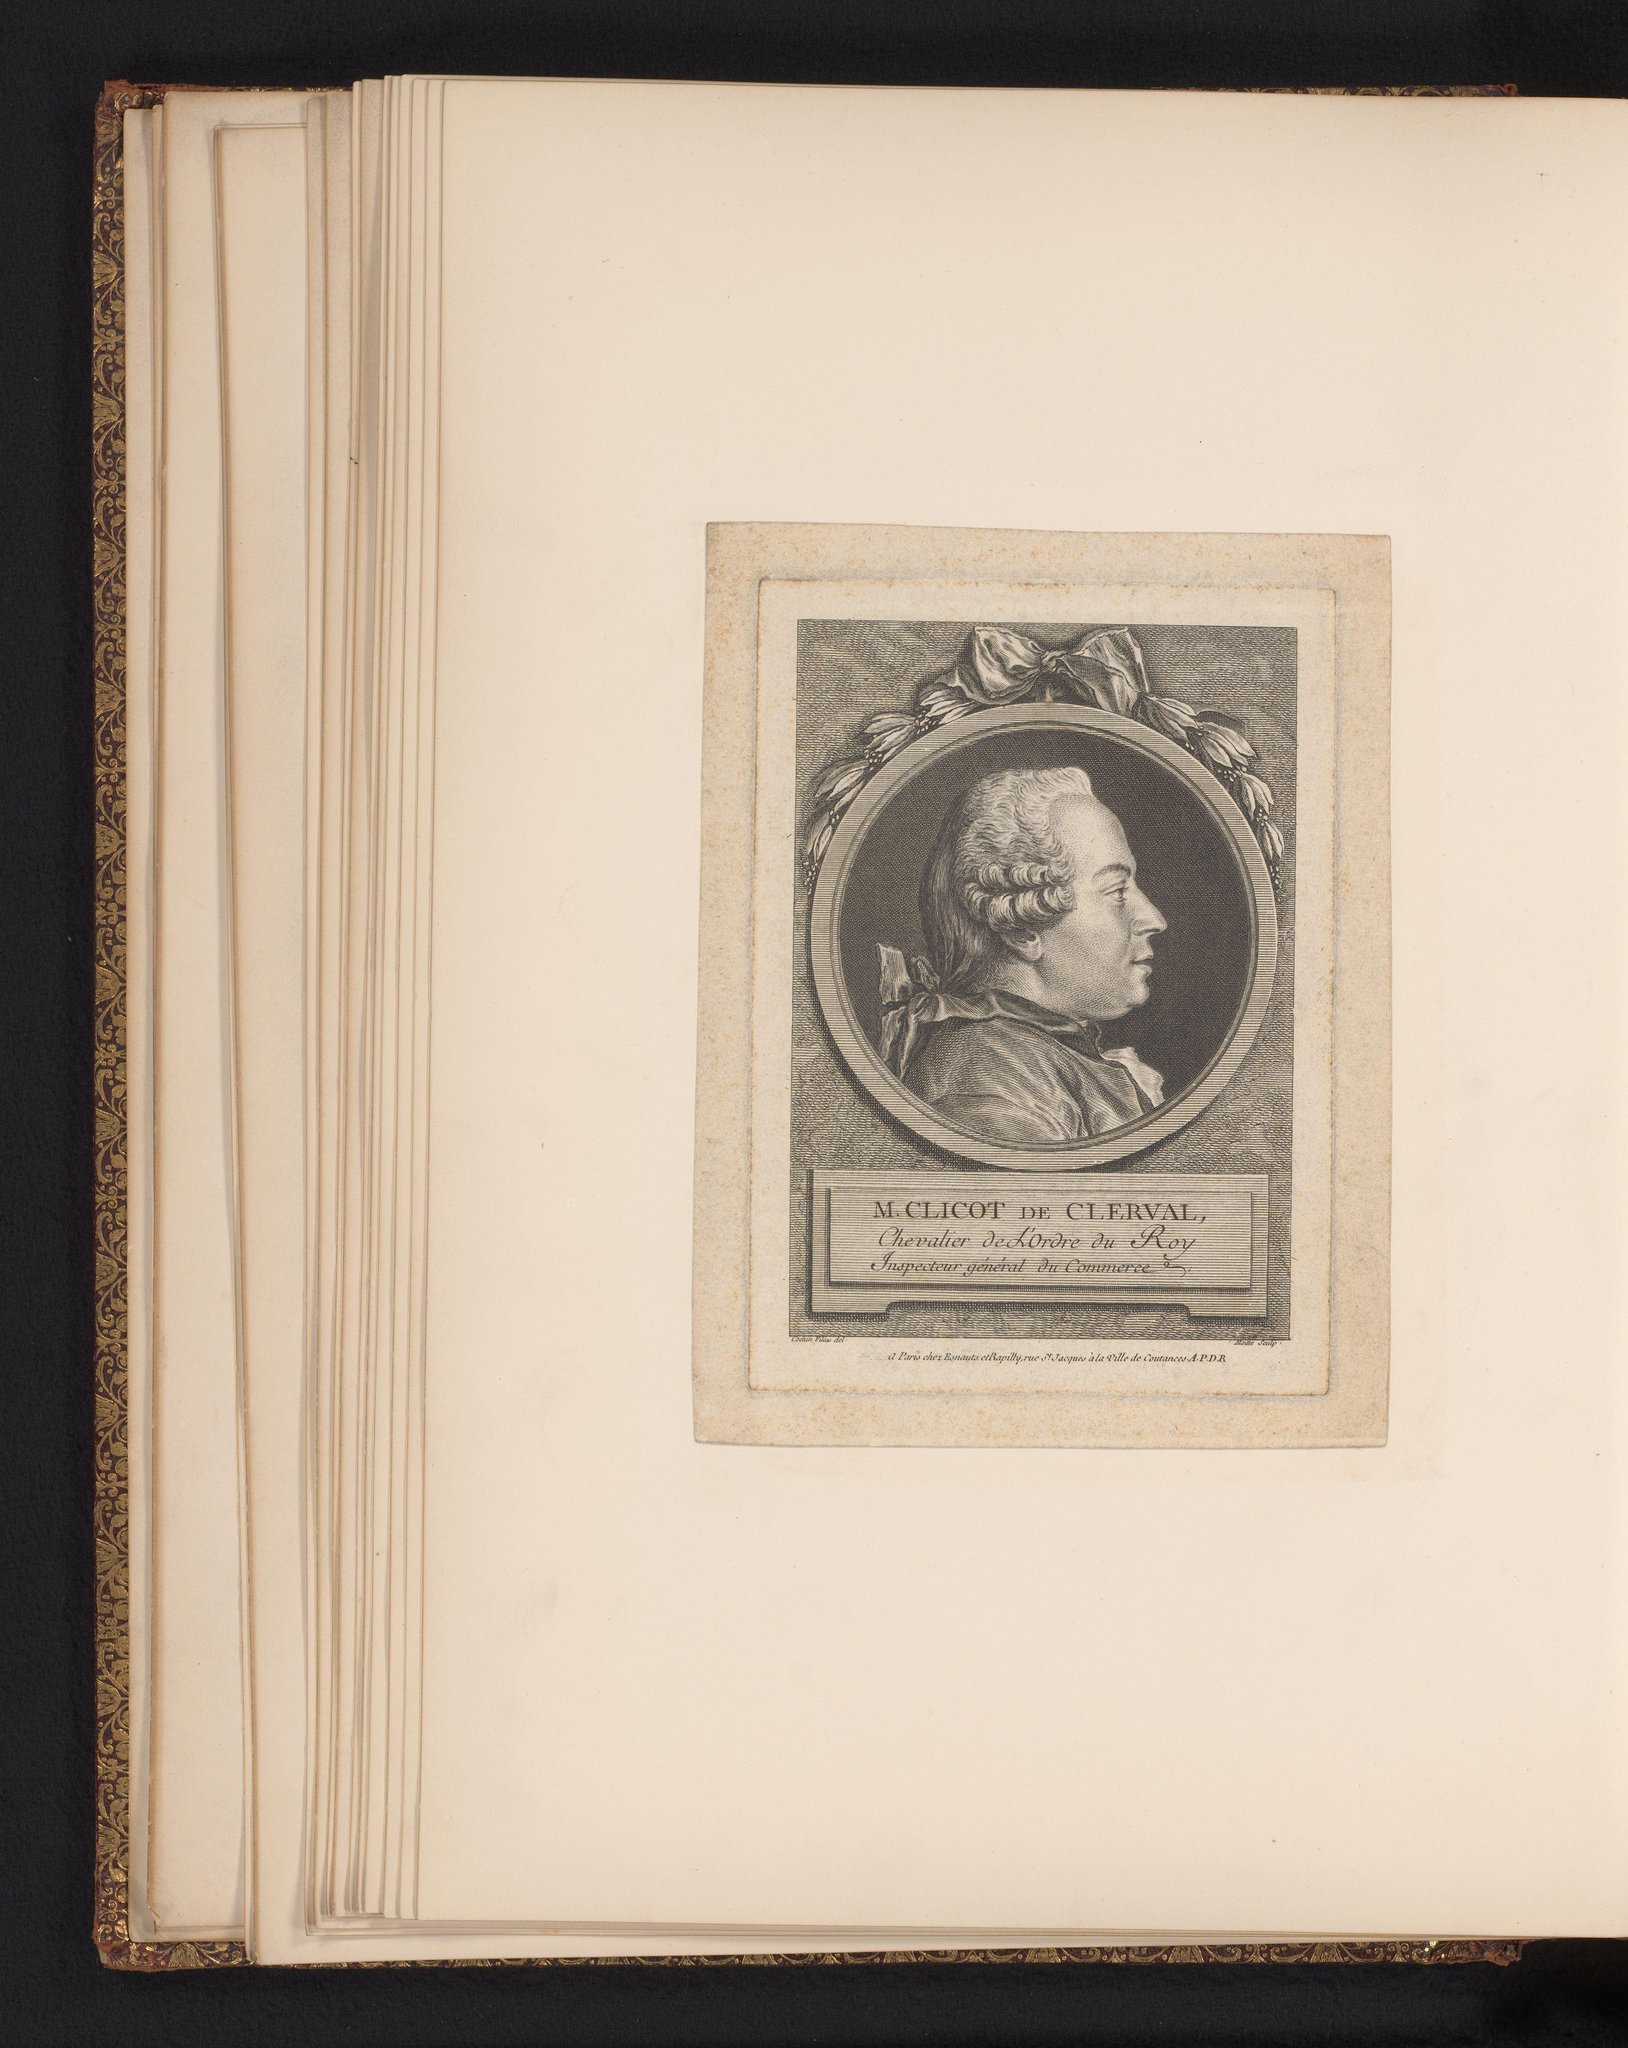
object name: album leaf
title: Portret van Clicot de Clerval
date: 1766-1780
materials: paper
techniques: engraving, etching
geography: paris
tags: historical persons